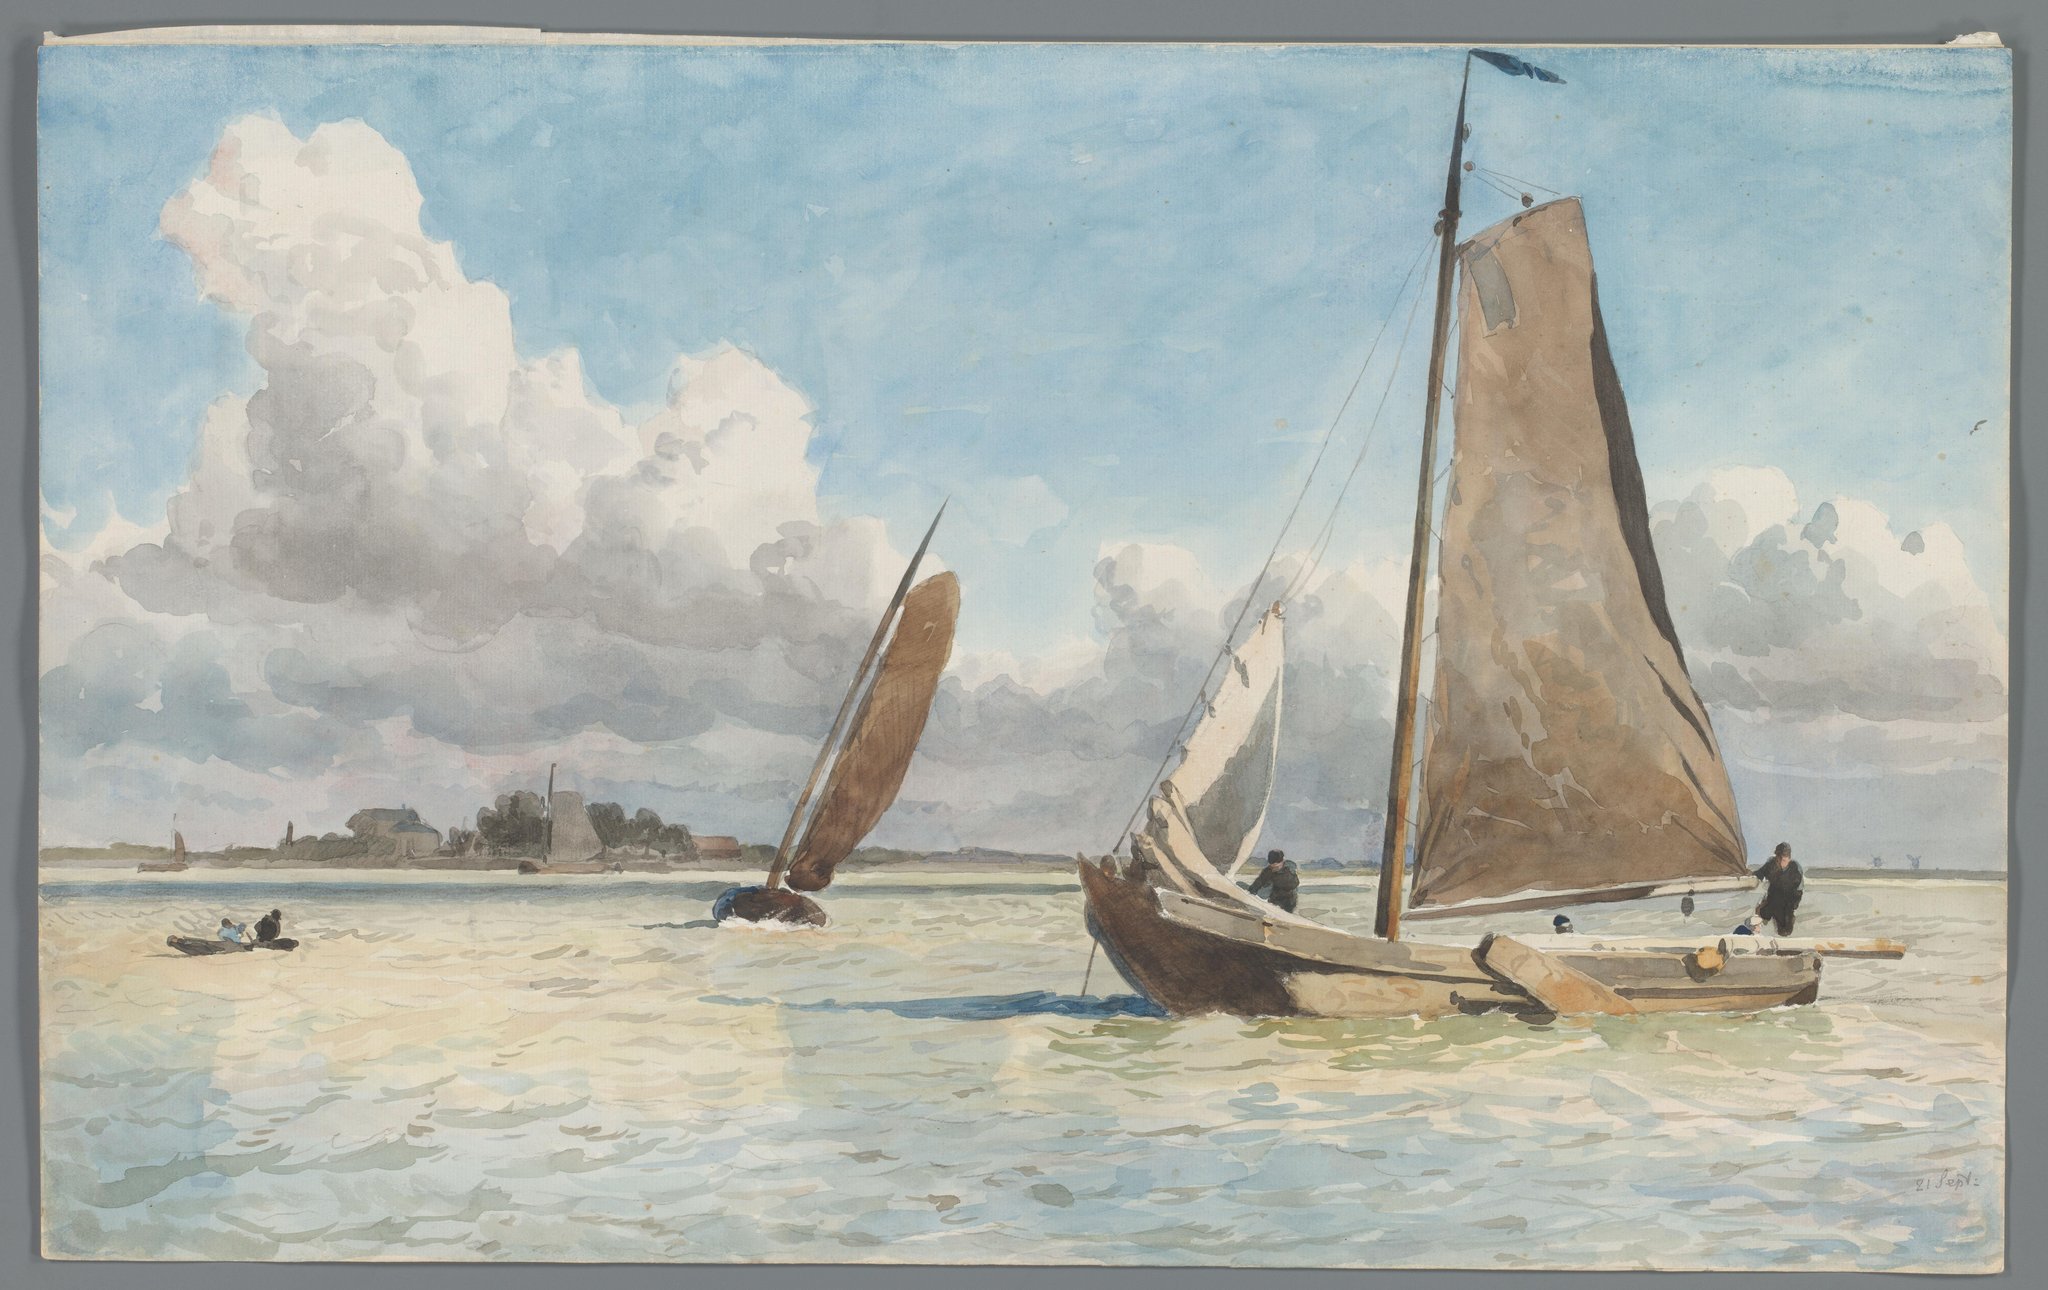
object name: watercolor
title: Vissers op het water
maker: willem anthonie van deventer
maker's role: draughtsman, painter, print maker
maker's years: 1824-1893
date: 1834-1893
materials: paper, pencil, watercolor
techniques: brush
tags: sailing-ship, sailing-boat, sea (seascape)